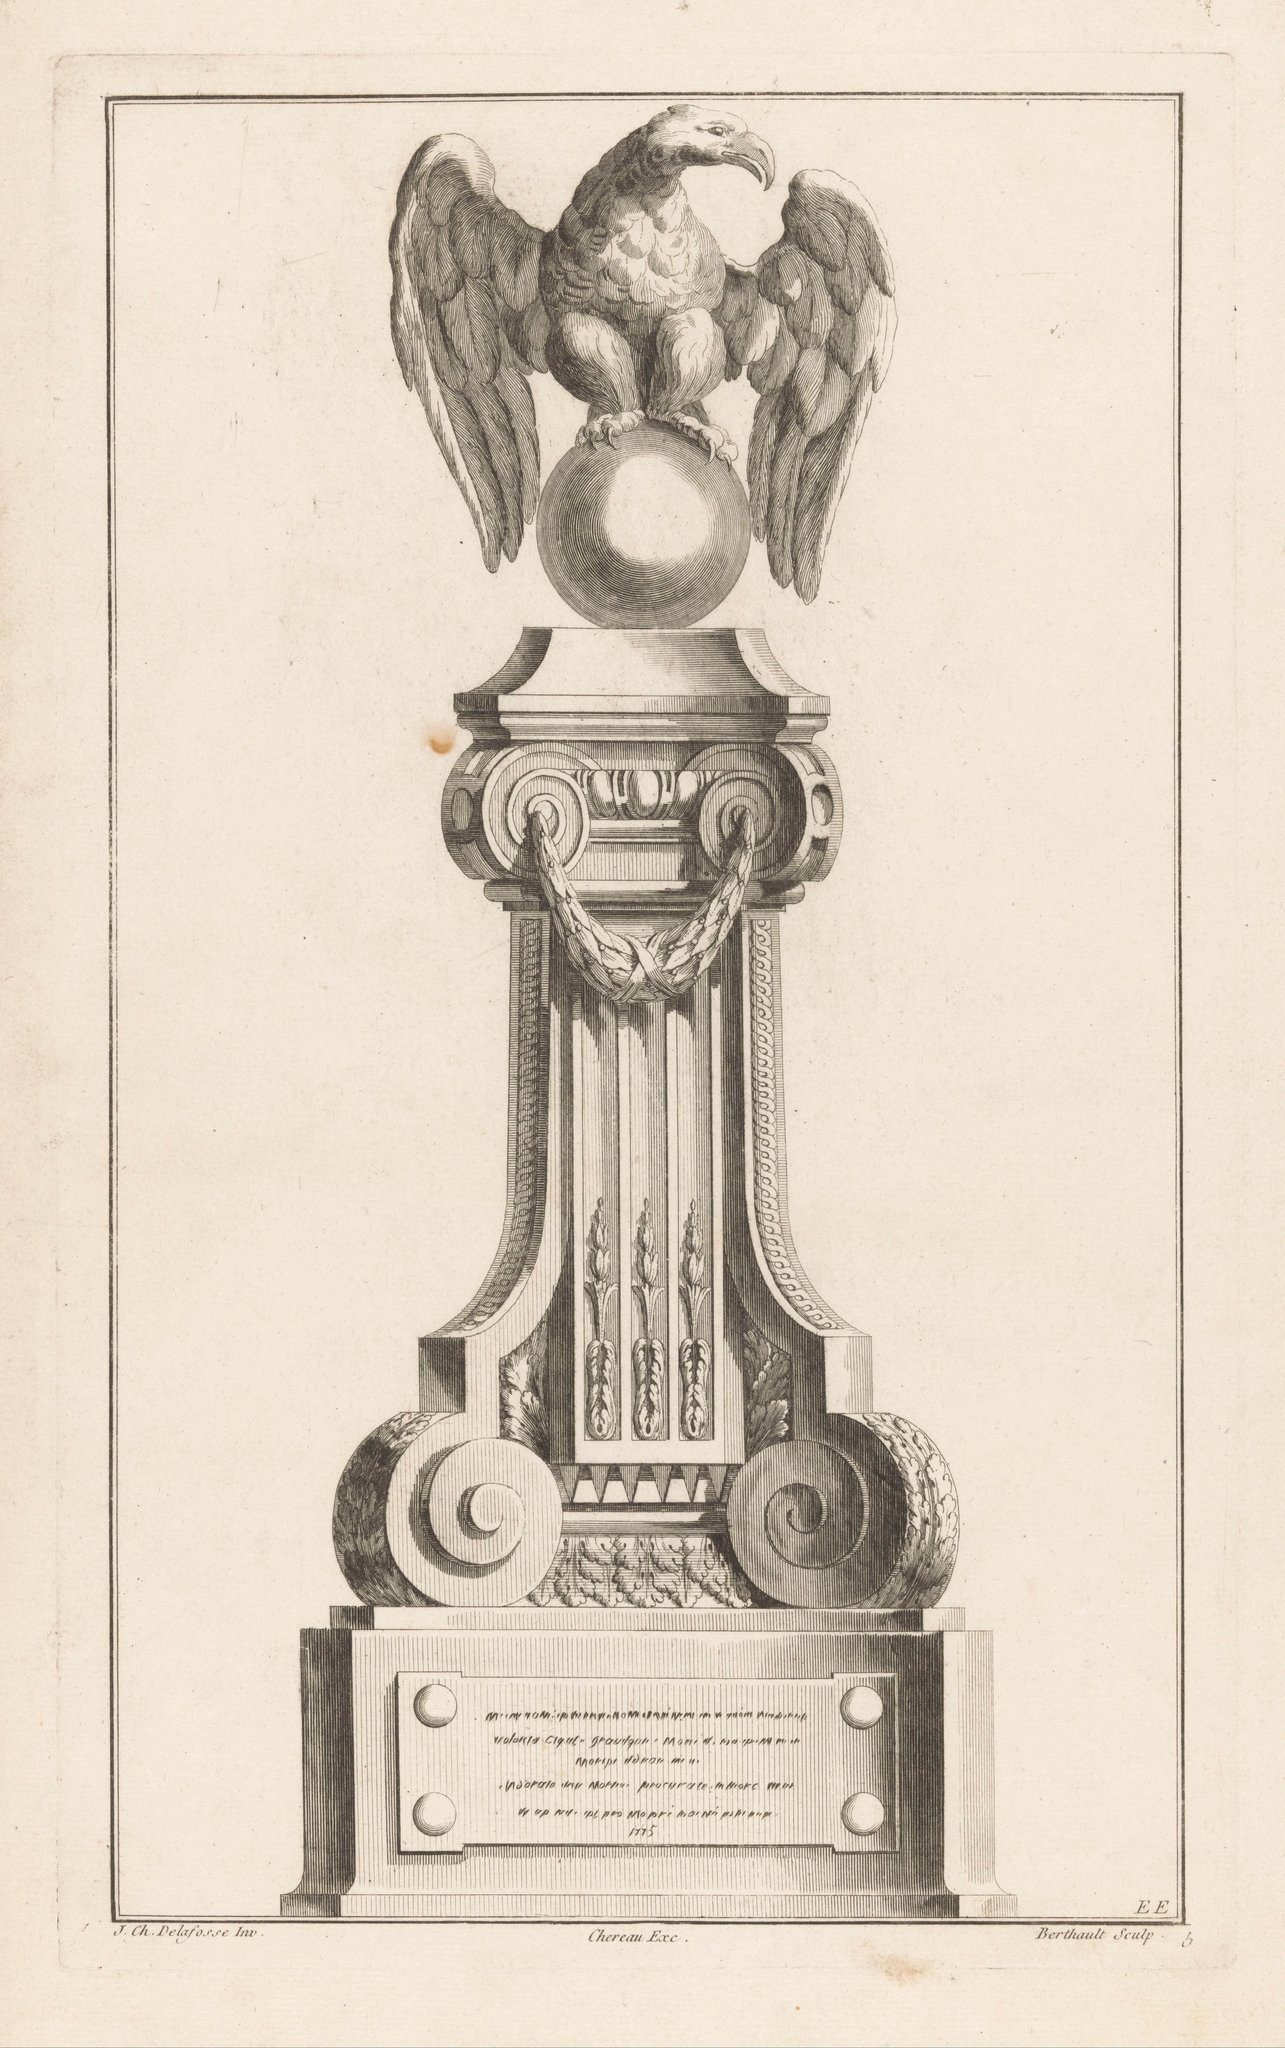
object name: ornament print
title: Lessenaar met adelaar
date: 1771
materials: paper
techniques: engraving, etching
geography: paris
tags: lectern, predatory birds: eagle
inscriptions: collector's mark: Lugt 2760, collector's mark: Lugt 2228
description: Een geornamenteerde lessenaar met een guirlande en een adelaar op een globe.